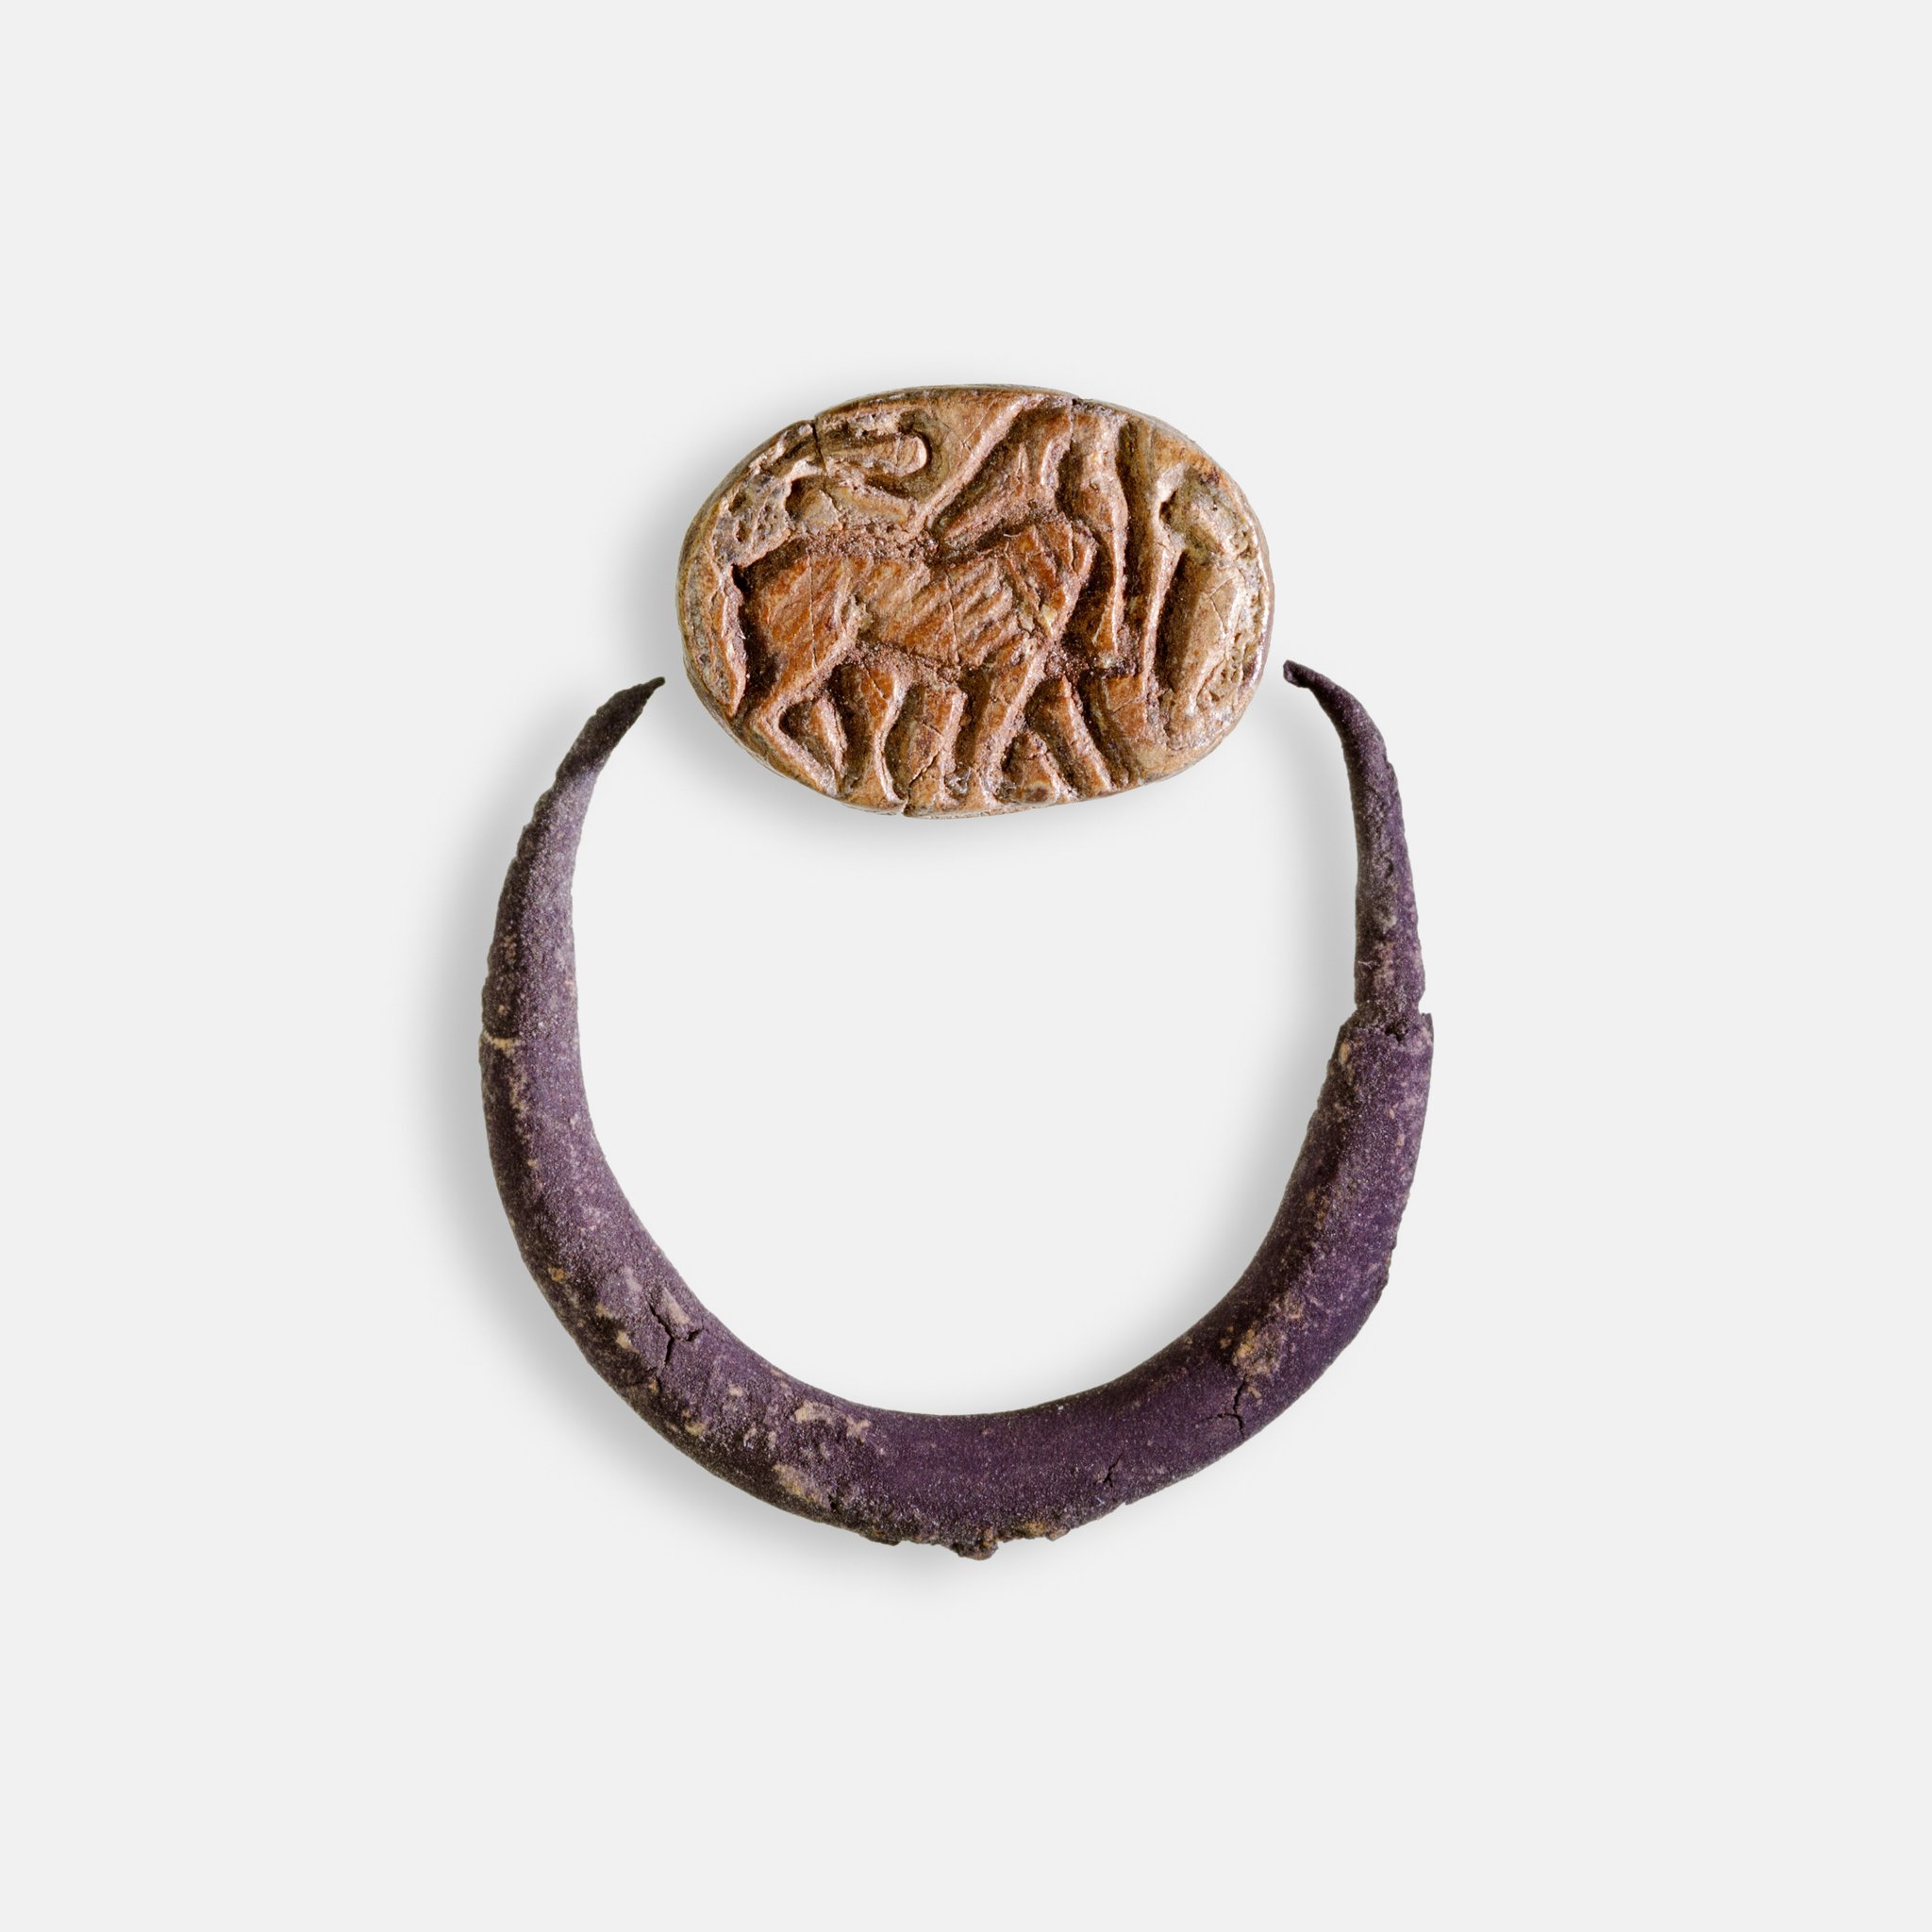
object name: ring, ruiu, scarab, standing sphinx, cobra, uraeus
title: Scarab Ring of Ruiu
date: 1504-1447 BCE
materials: silver, stone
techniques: glazing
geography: egypt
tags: scarabs